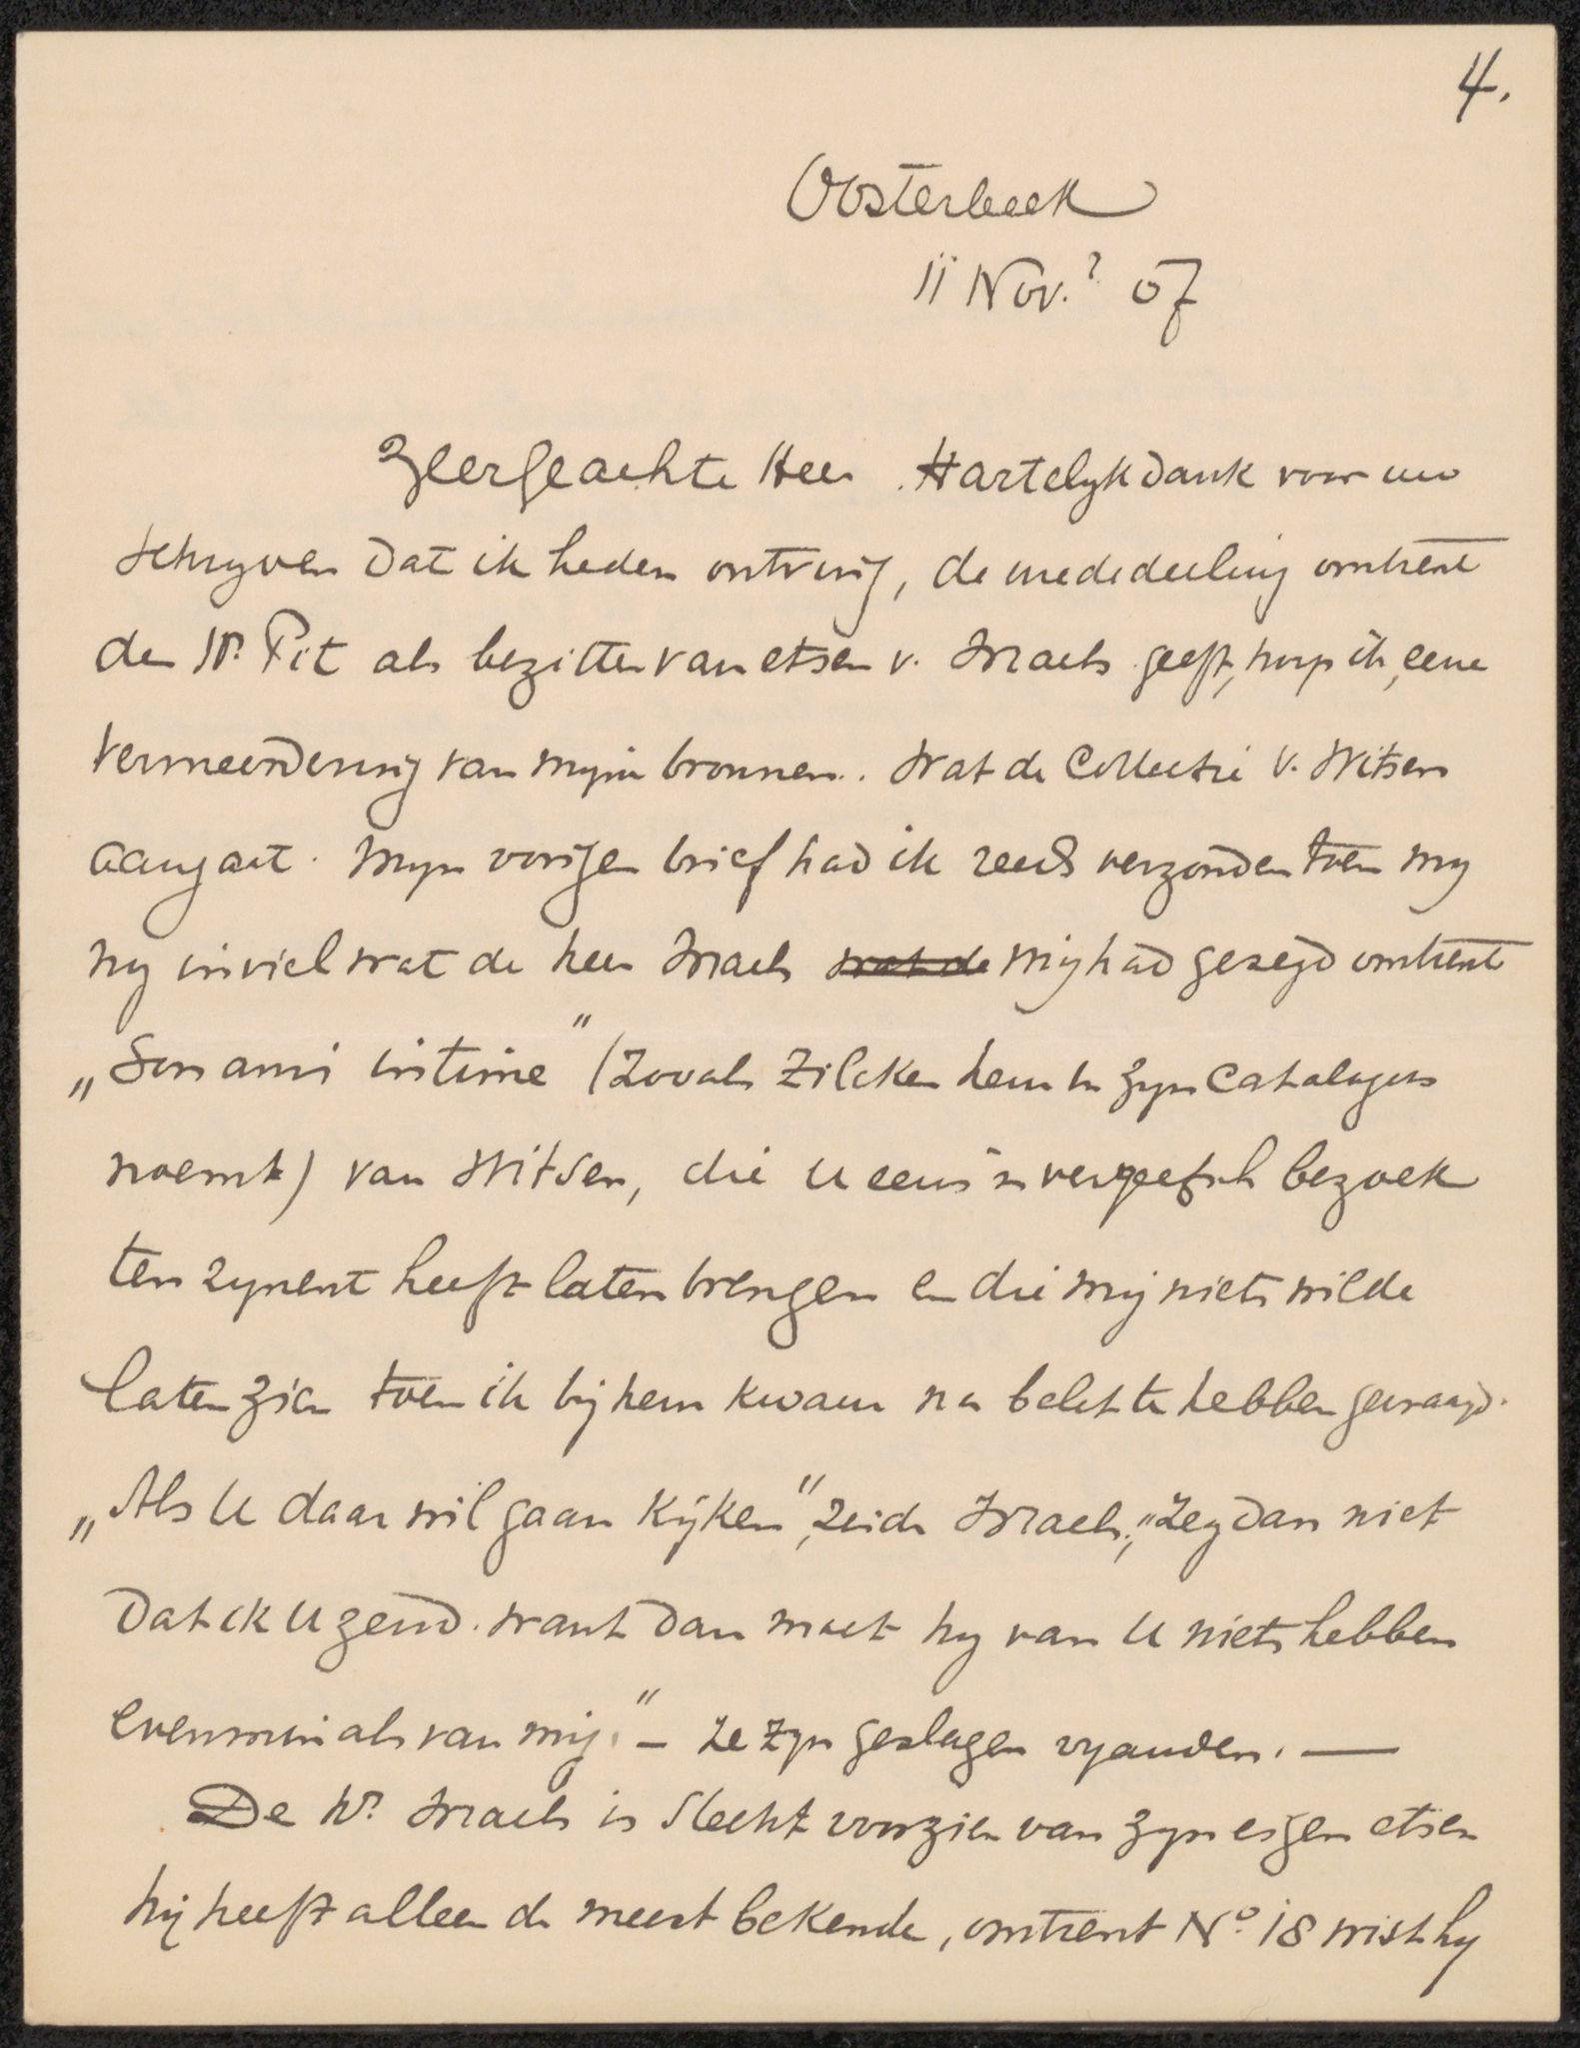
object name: letter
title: Brief aan Pieter Haverkorn van Rijsewijk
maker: h.j. hubert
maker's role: auteur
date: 1907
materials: ink, paper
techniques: pen, writing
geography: oosterbeek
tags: jozef israëls, amsterdam, print maker, willem witsen, nijmegen, adriaan pit, sientje mesdag-van houten, london, francis seymour-haden (sir), pieter haverkorn van rijsewijk, paris, alfred cadart, the hague, painter, draughtsman, philip zilcken, the graphic arts, exhibition ~ art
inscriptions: collector's mark: ‘RPK’